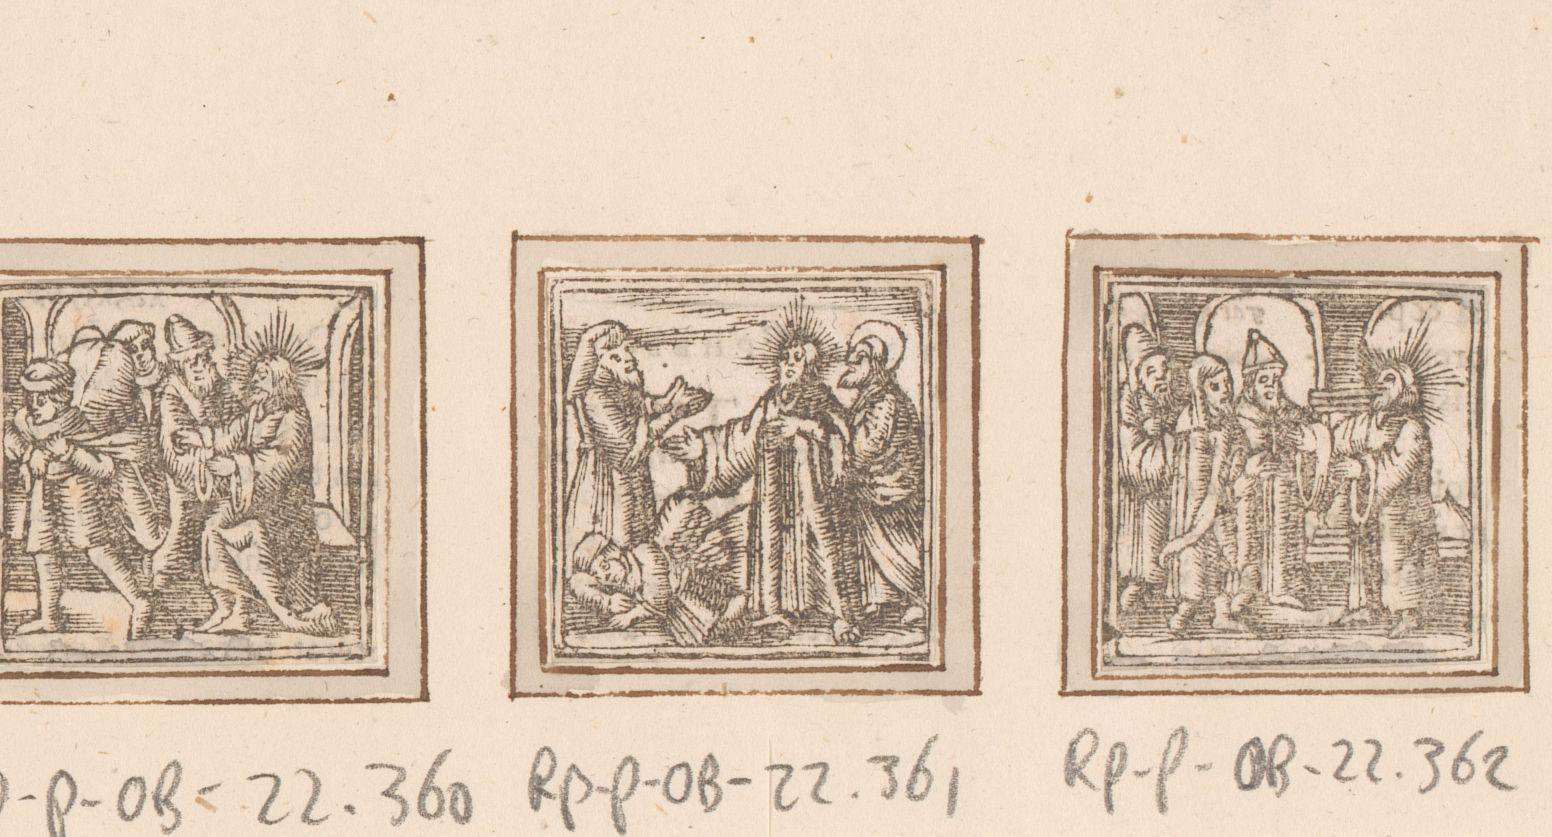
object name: print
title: Christus geneest een zieke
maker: Anonymous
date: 1590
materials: paper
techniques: woodcut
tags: miracles of christ ~ healing the sick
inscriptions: collector's mark: Lugt 240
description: Prent afkomstig uit een onbekende Latijnse bijbel, mogelijk gedateerd 1590.